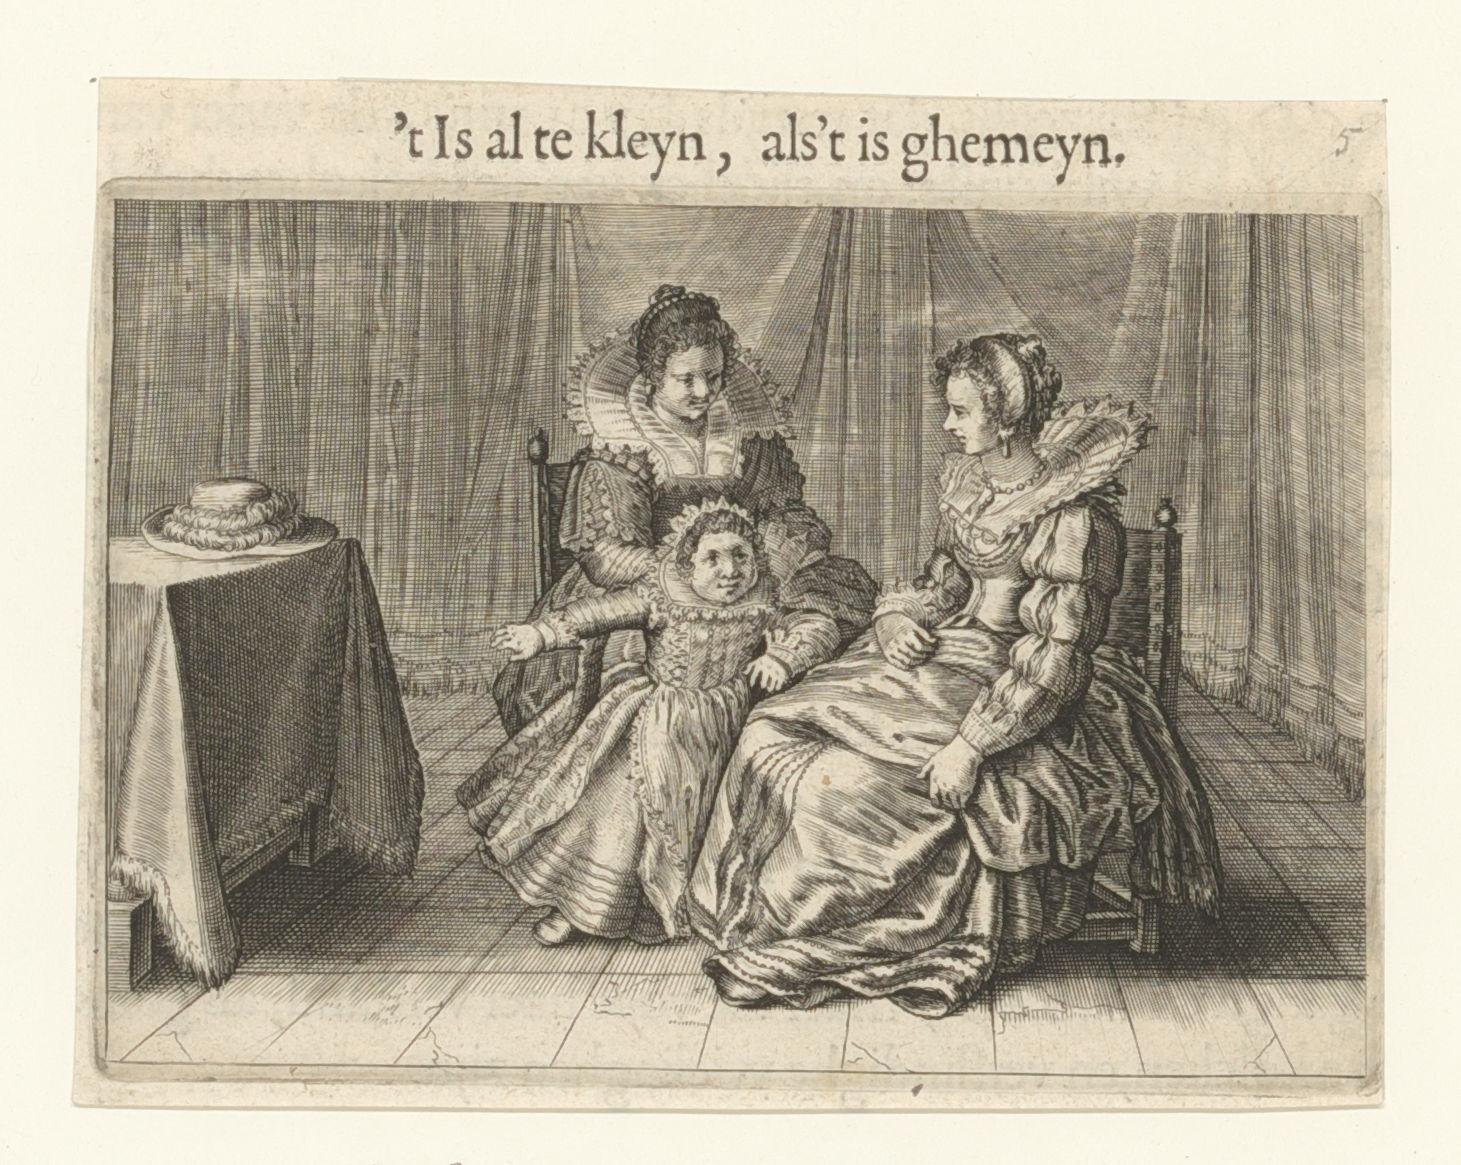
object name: book illustration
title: 't Is al te kleyn, als 't is ghemeyn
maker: Anonymous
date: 1624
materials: paper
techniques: engraving, letterpress printing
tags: secret, proverbs, sayings, etc., mother and baby or young child, humility; 'humiltà' (ripa), fashionable woman, 'belle'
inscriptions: stamp, collector's mark: Lugt 1641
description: Embleem uit: Brune, Johan de. Zinne-werck, Voor-ghesyelt in Beelden, Ghedichten, ende breeder uyt-legginghen (...). Amsterdam: Evertsen Kloppenburch, 1624. Prent ook gebruikt in latere edities (1636 en 1661).